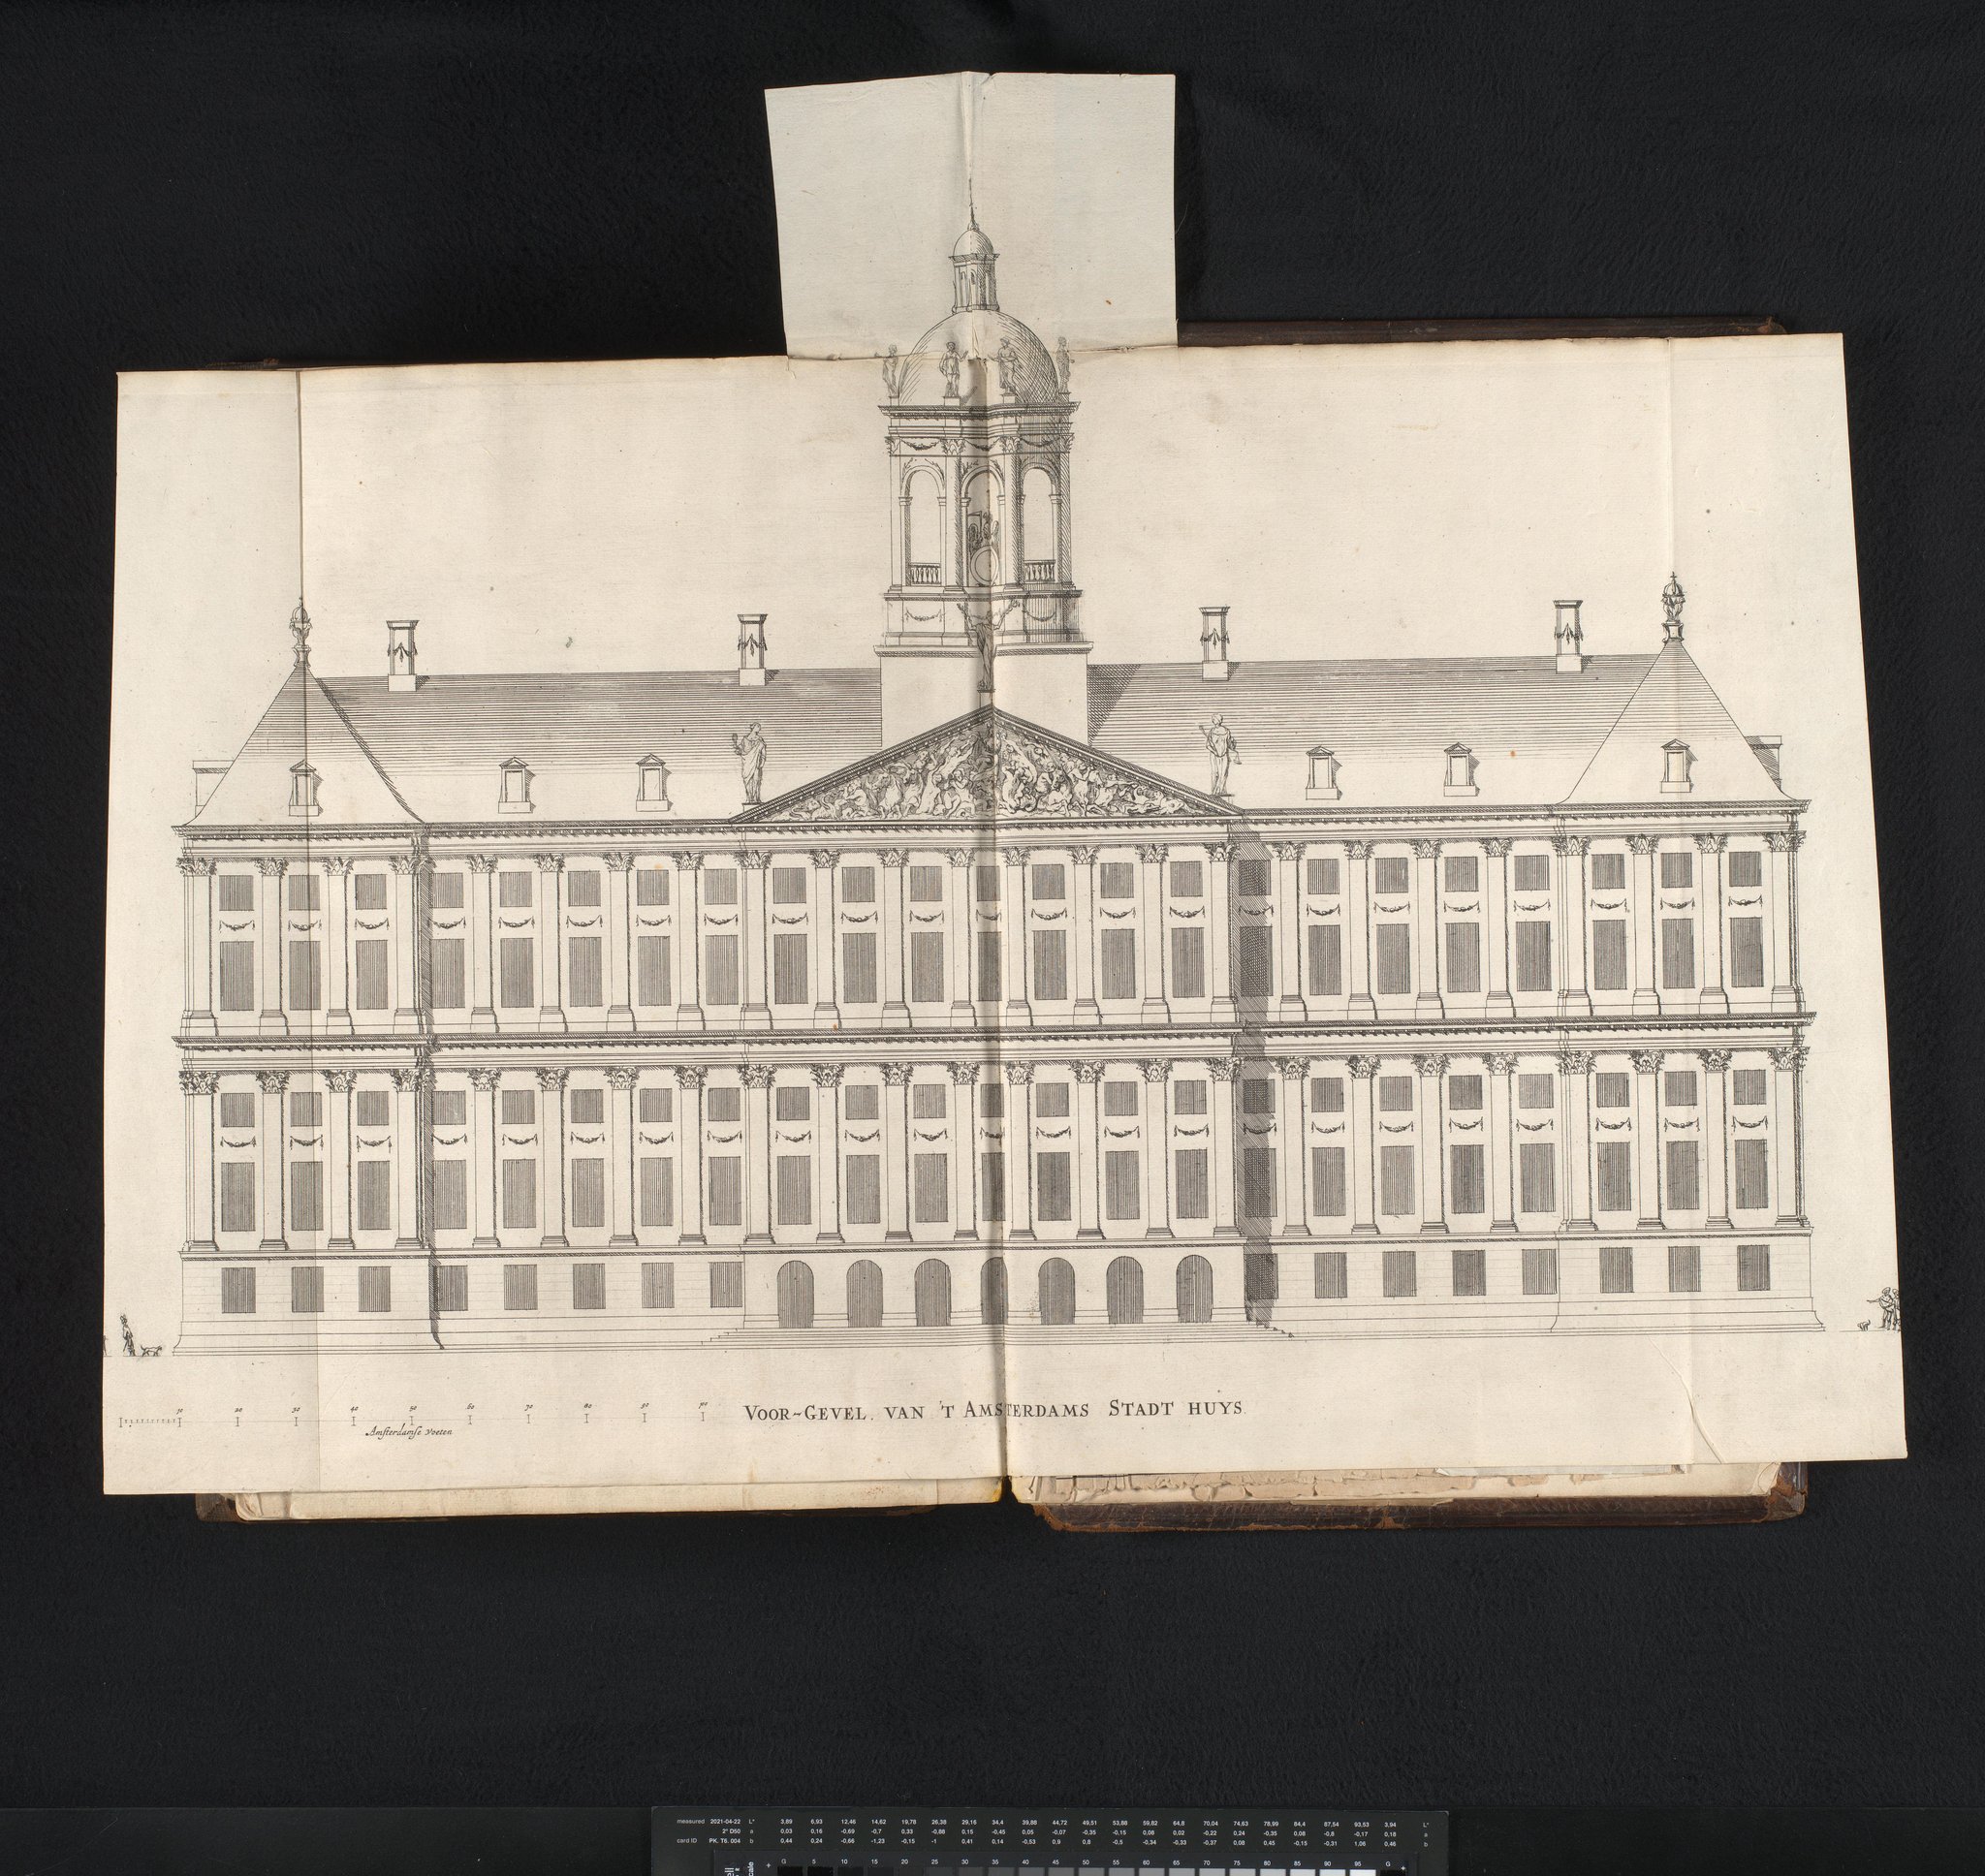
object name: print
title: Voorgevel (oostzijde) van het Stadhuis op de Dam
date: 1650-1675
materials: paper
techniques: etching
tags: townhall, exterior ~ representation of a building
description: Met onderaan een schaalaanduiding. Prent maakt deel uit van een convoluut.